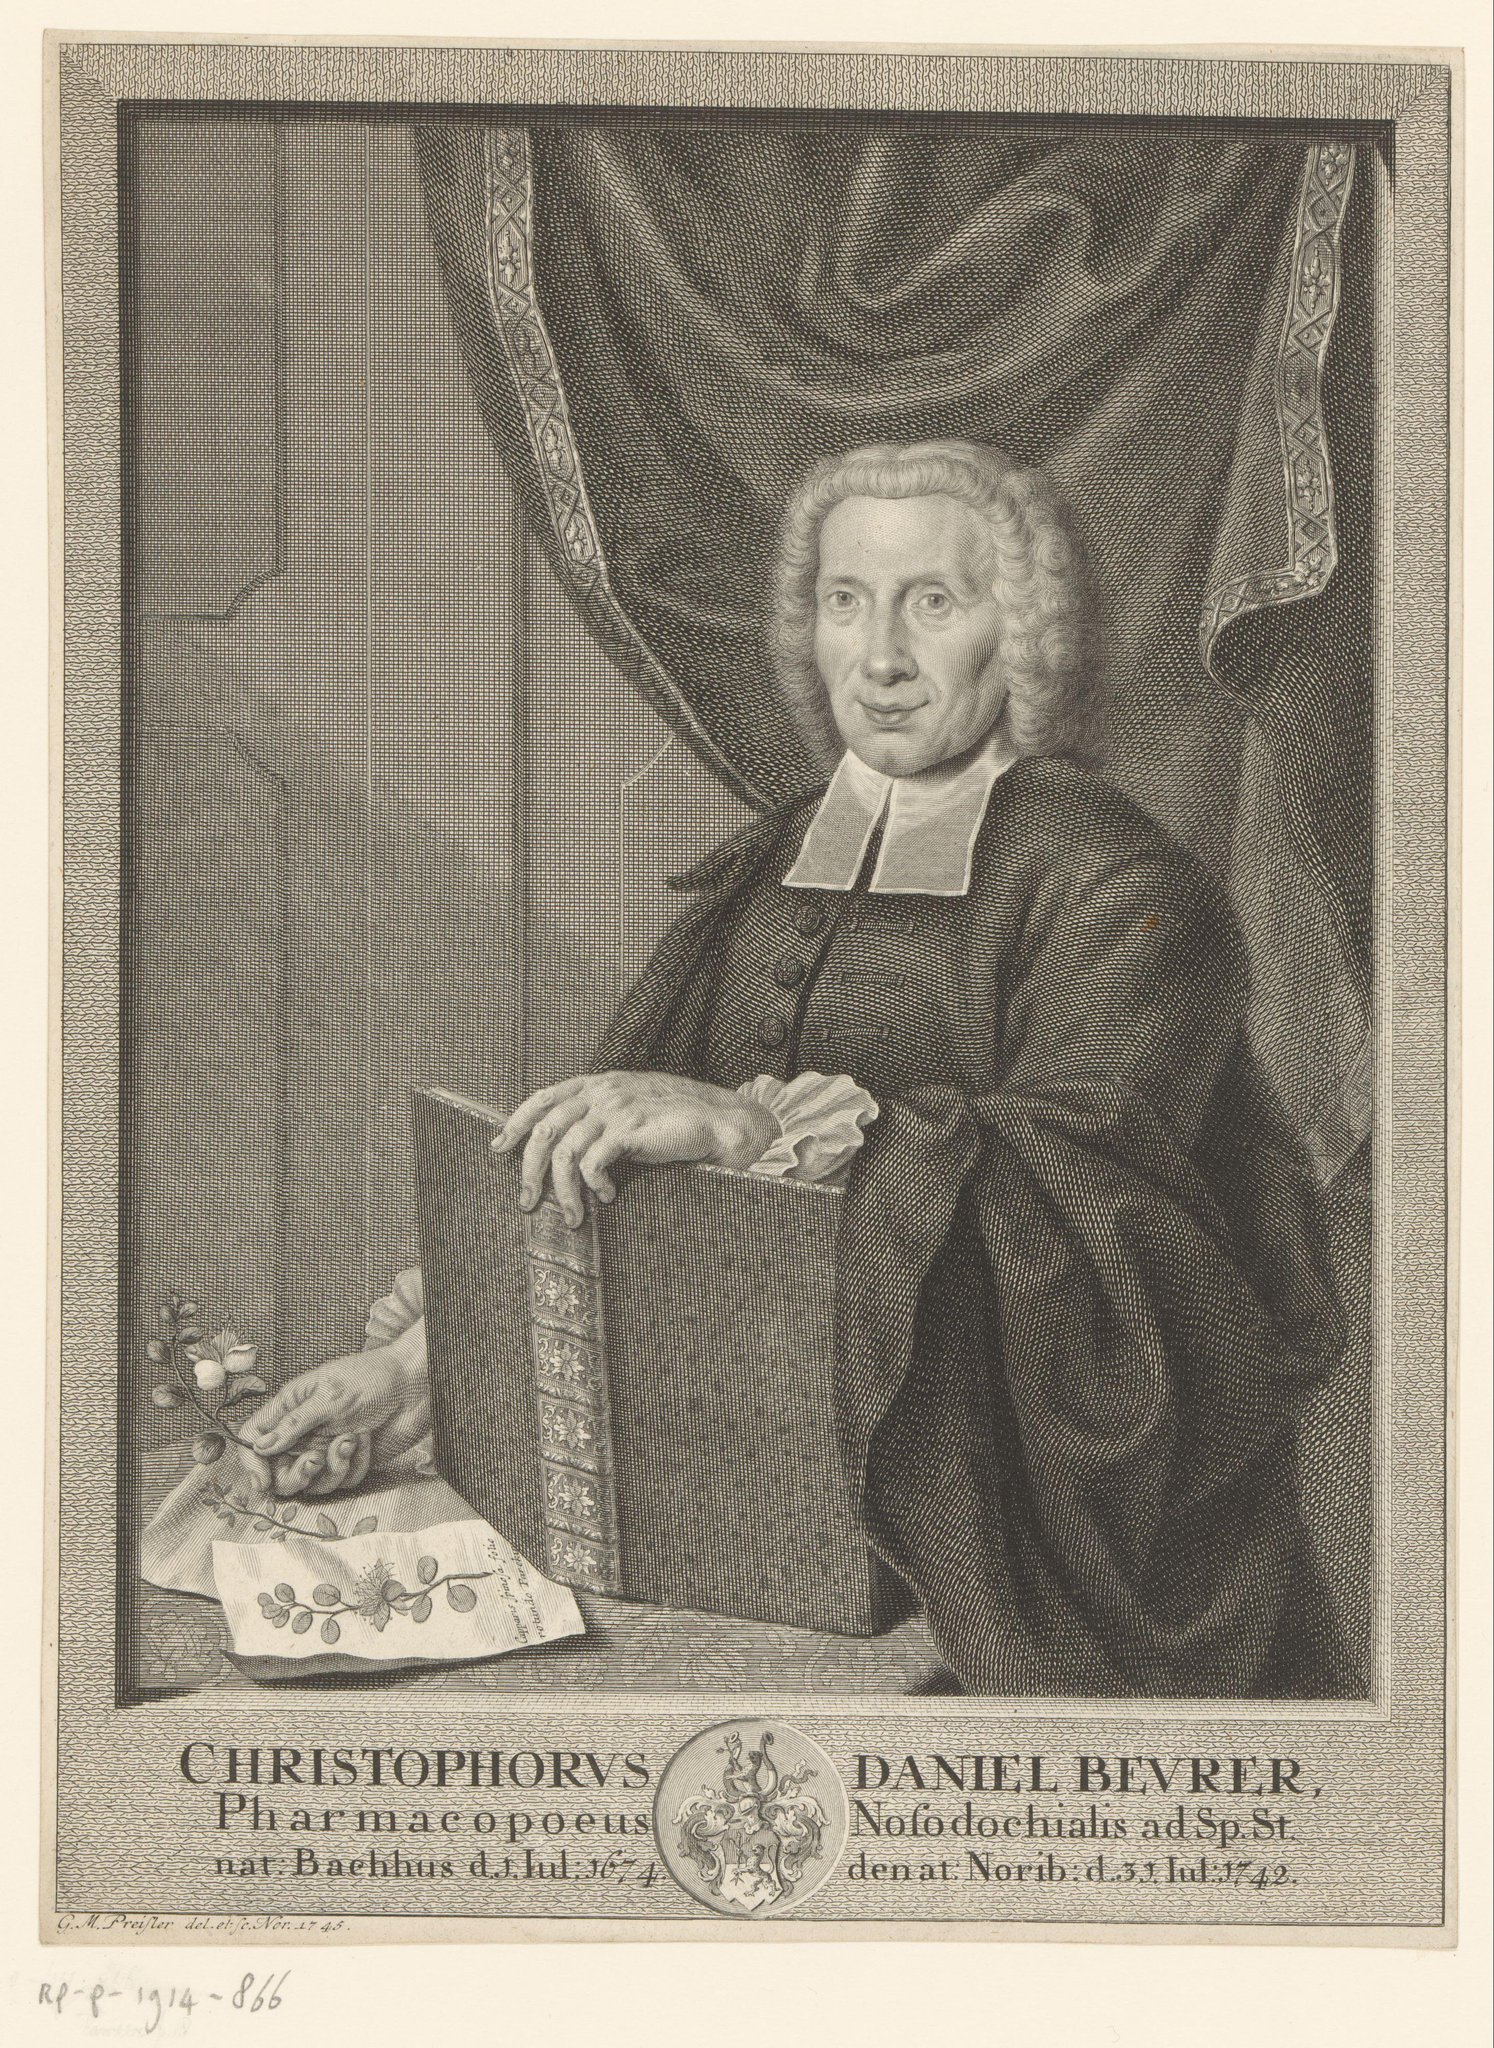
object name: print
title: Portret van Christoph Daniel Beurer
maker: georg martin preissler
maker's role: print maker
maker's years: 1700-1754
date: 1745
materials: paper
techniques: engraving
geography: nuremberg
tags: historical persons, book, botany, armorial bearing, heraldry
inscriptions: collector's mark: Lugt 2228